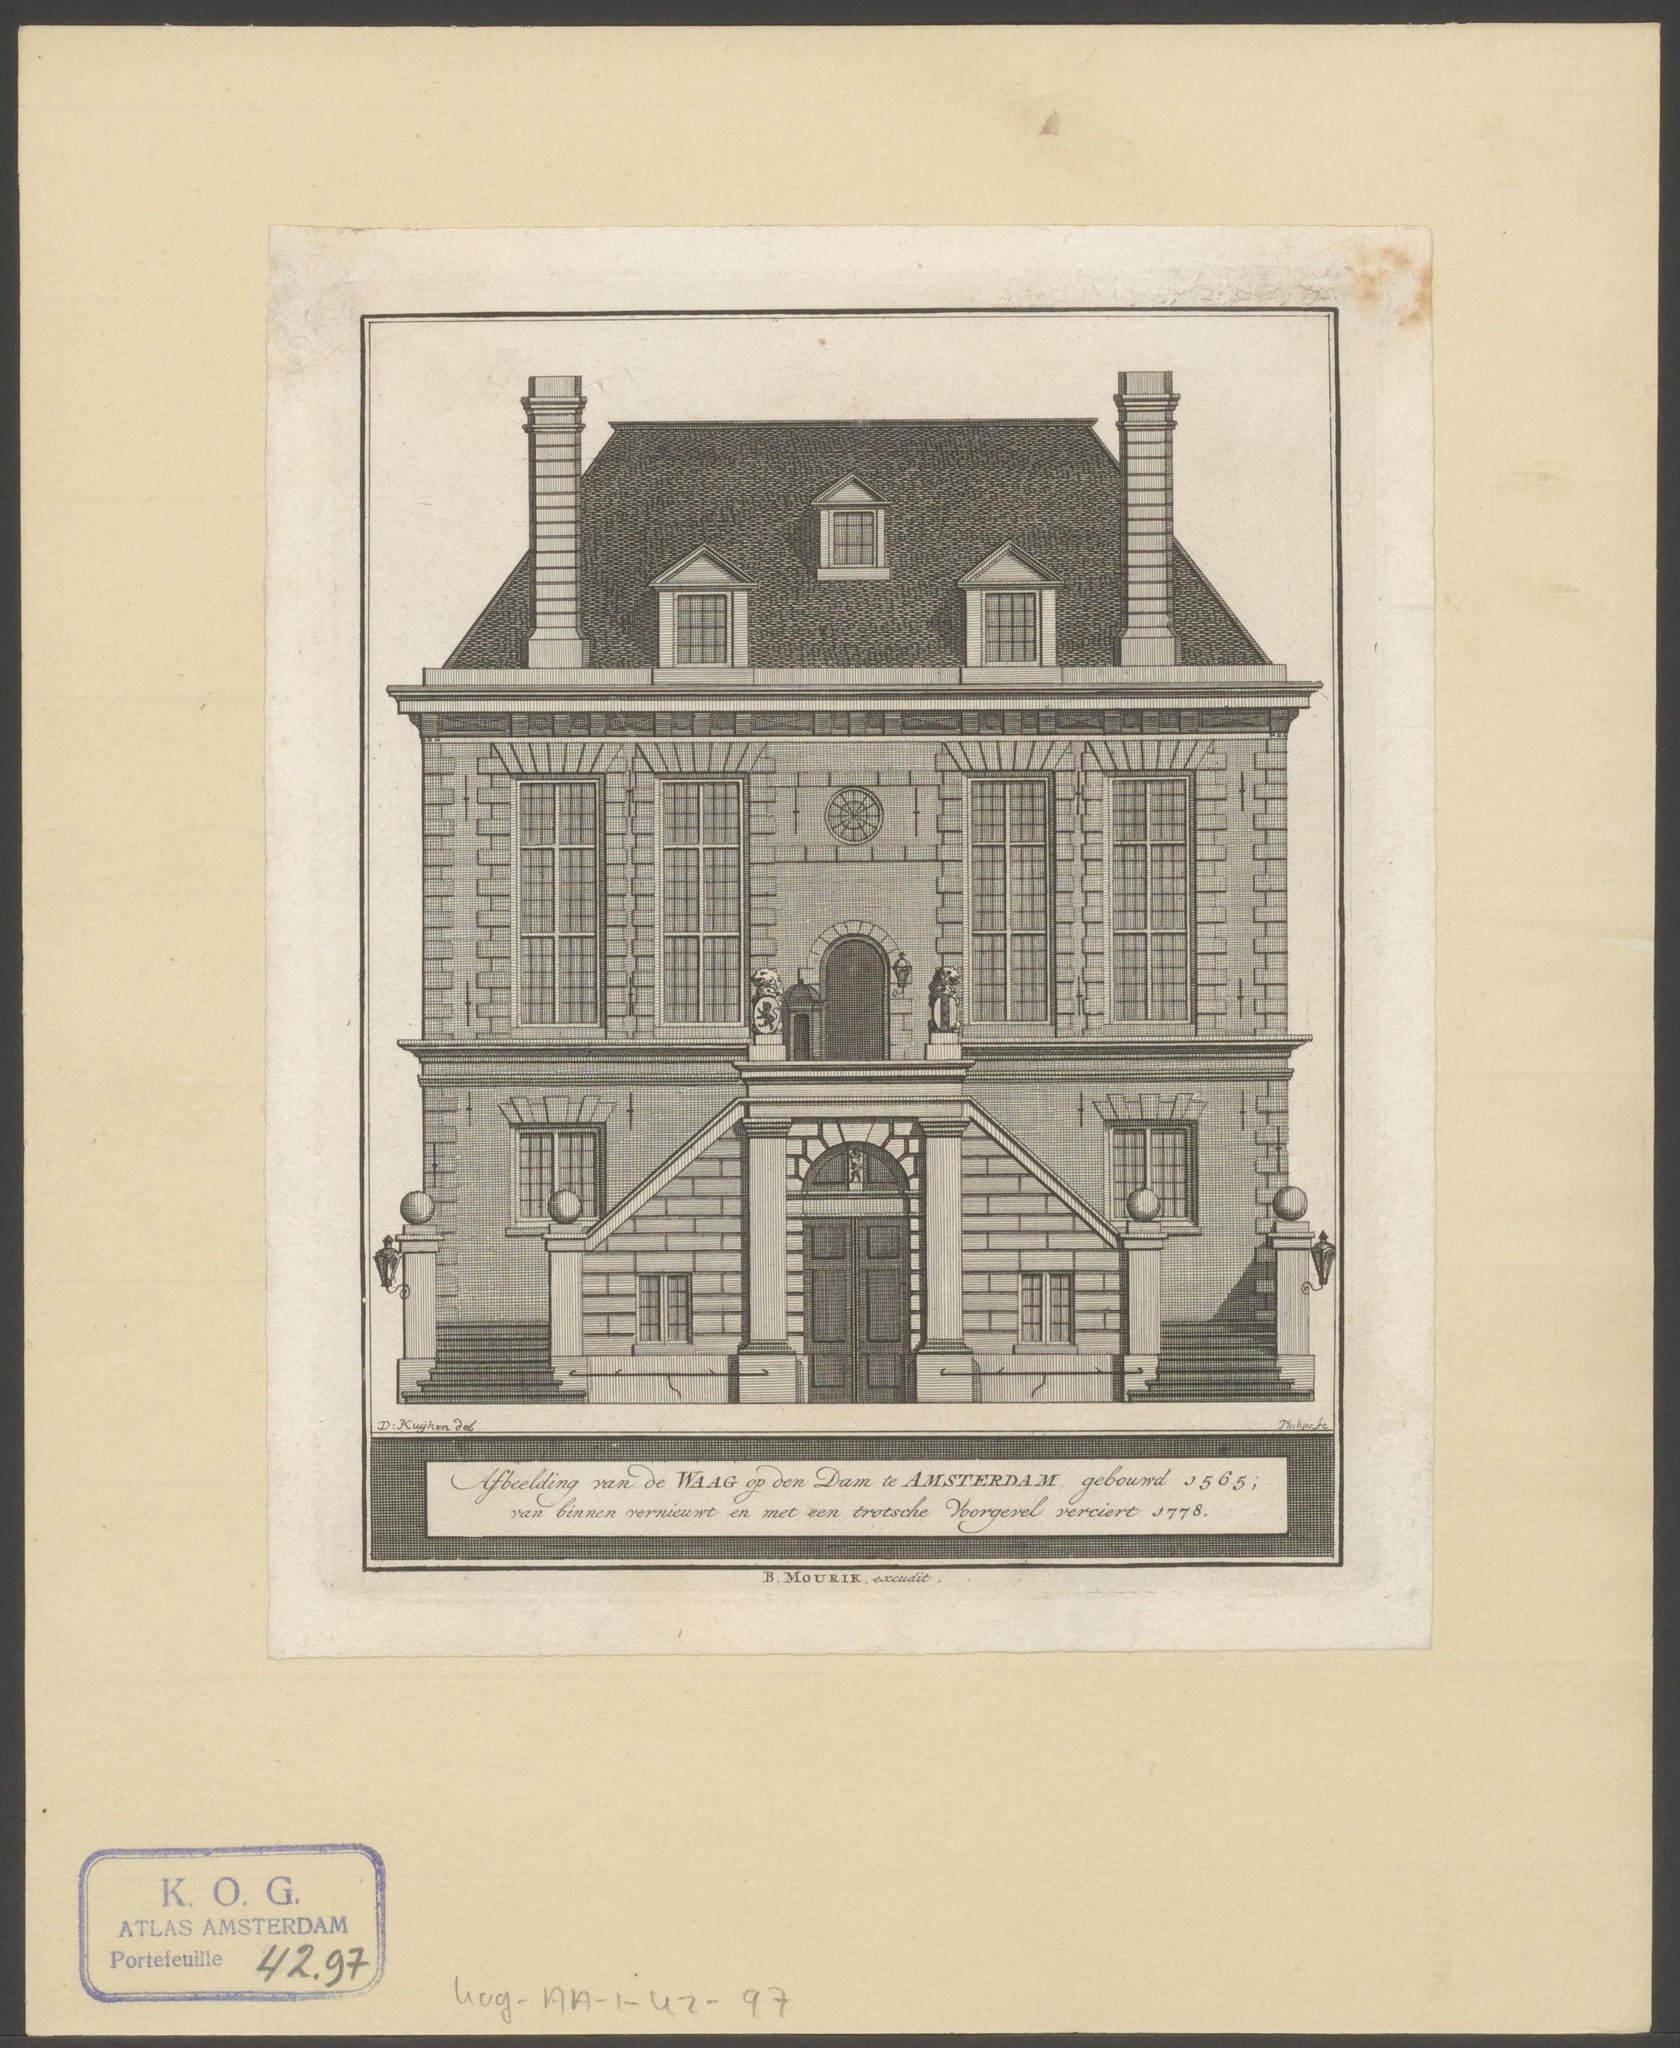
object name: print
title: Afbeelding van de Waag op den Dam te Amsterdam (...)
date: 1705-1778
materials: paper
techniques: engraving, etching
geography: amsterdam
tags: weigh-house, amsterdam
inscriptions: collector's mark: Lugt 1461b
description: Onderwerpsrubriek binnen de Atlas Amsterdam: Markten, handel: C. Veemen, Waaggebouwen.